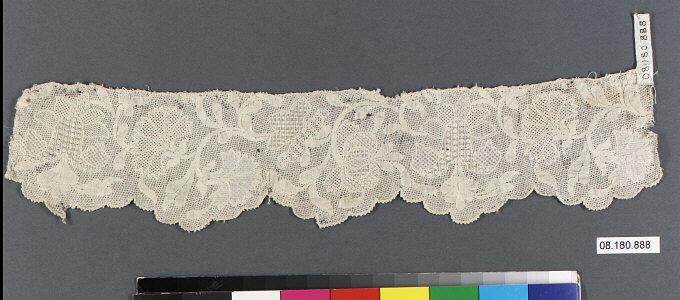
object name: fragment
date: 1701-1800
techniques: embroidery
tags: flowers